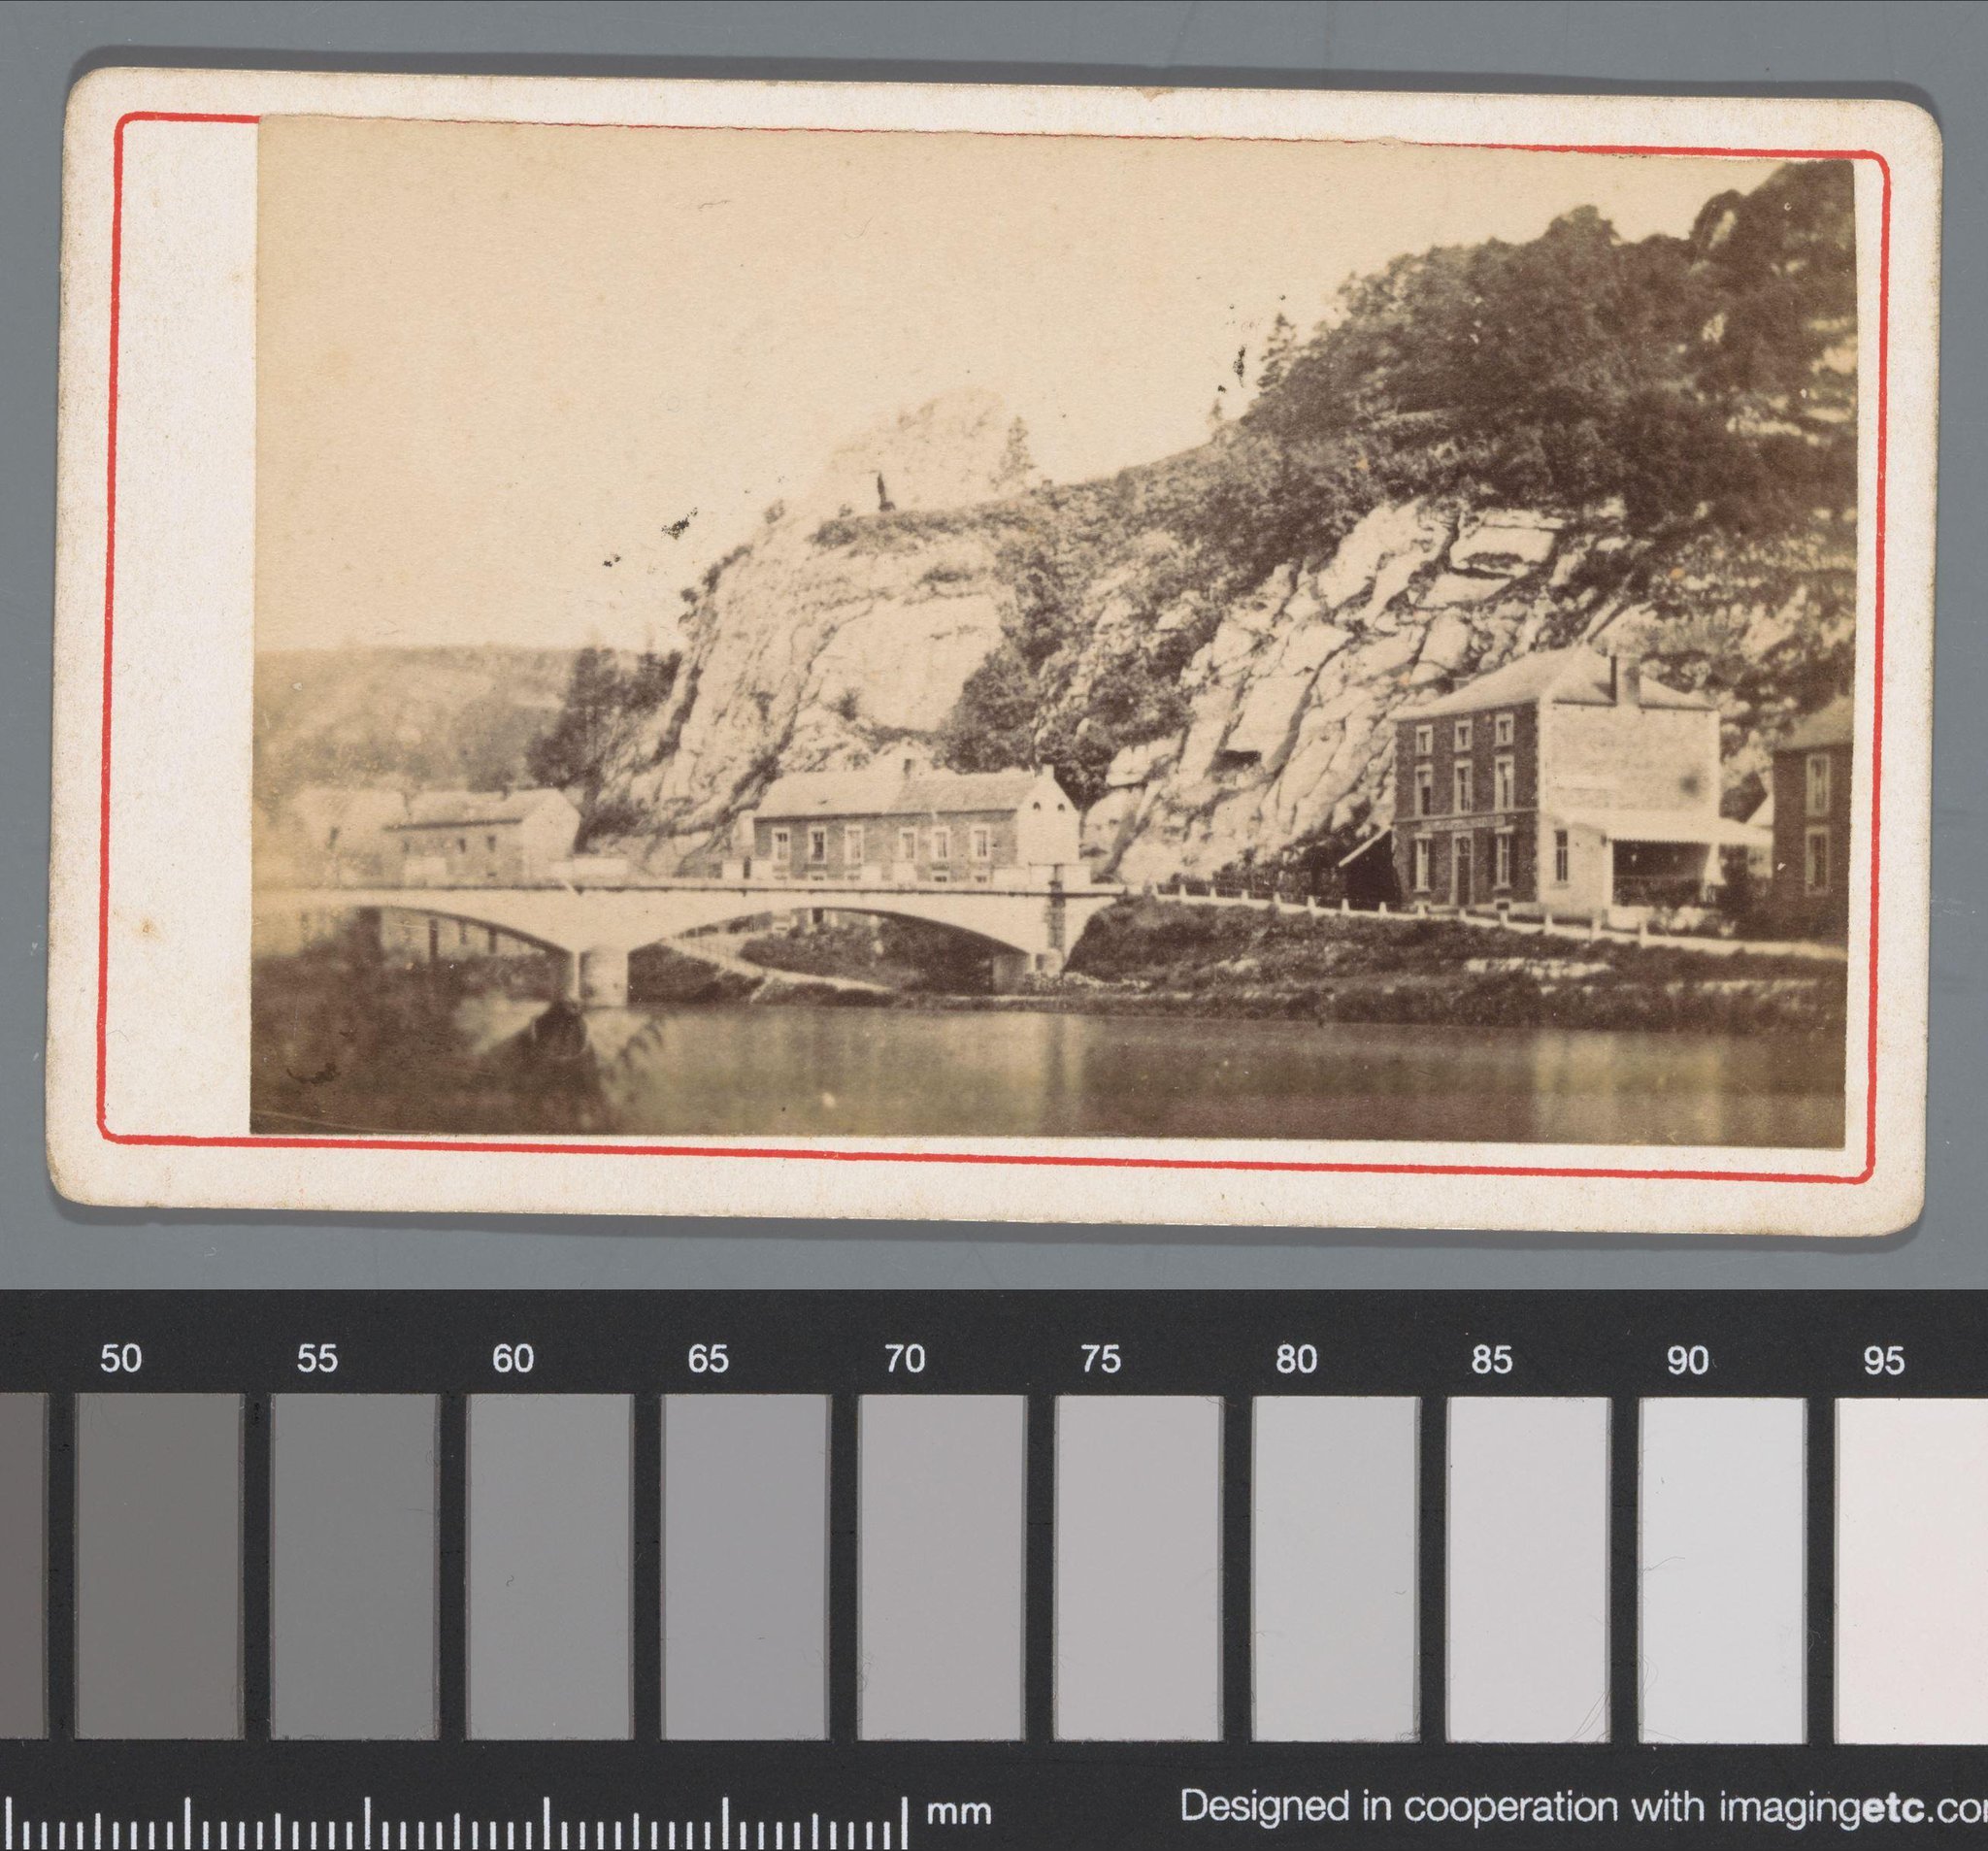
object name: carte de visite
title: Hotel du Pont à Esneux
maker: Anonymous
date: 1855-1885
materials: cardboard, paper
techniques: albumen print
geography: esneux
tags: river, rock-formations, hotel, hostelry, inn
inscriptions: inscription: ‘Tricot. Fassin’, inscription: ‘Esneux (België, ten zuiden Luik)’